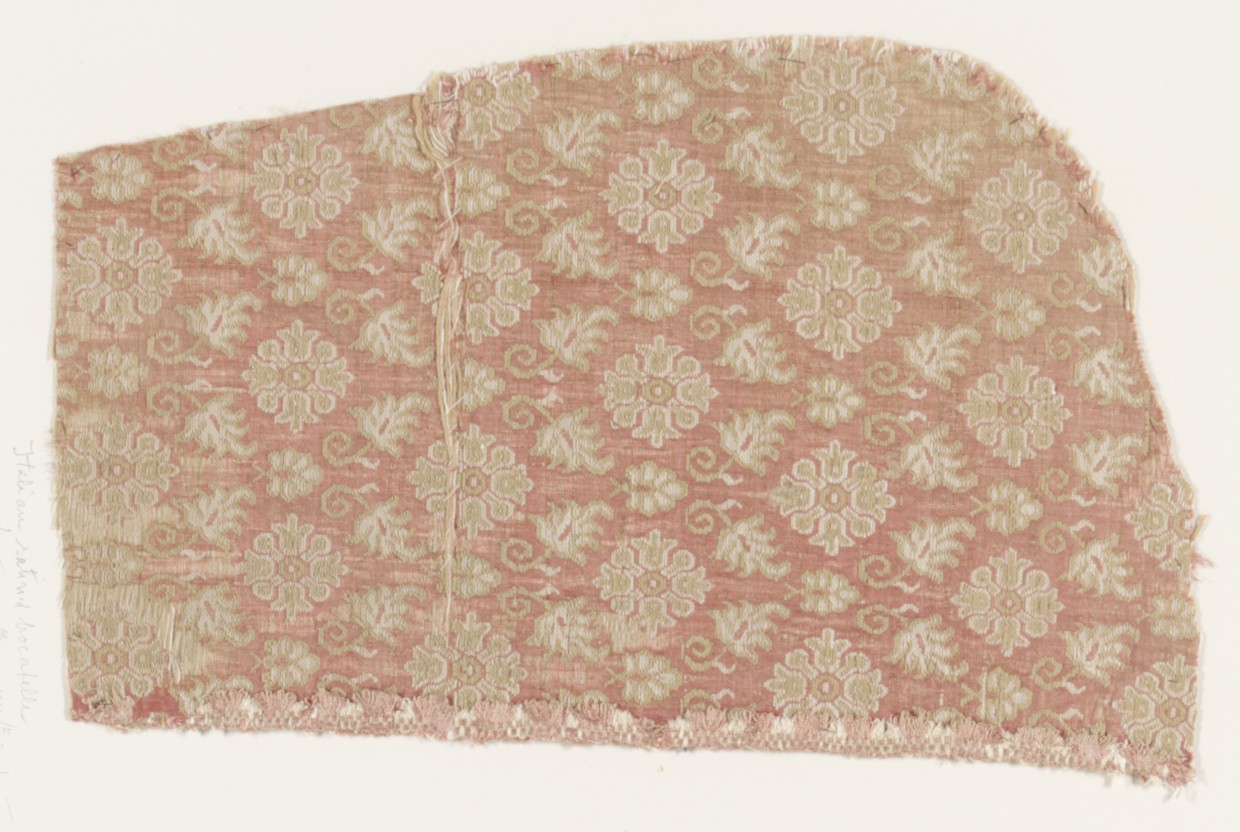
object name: fragment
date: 1501-1700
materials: silk, wool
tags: leaves